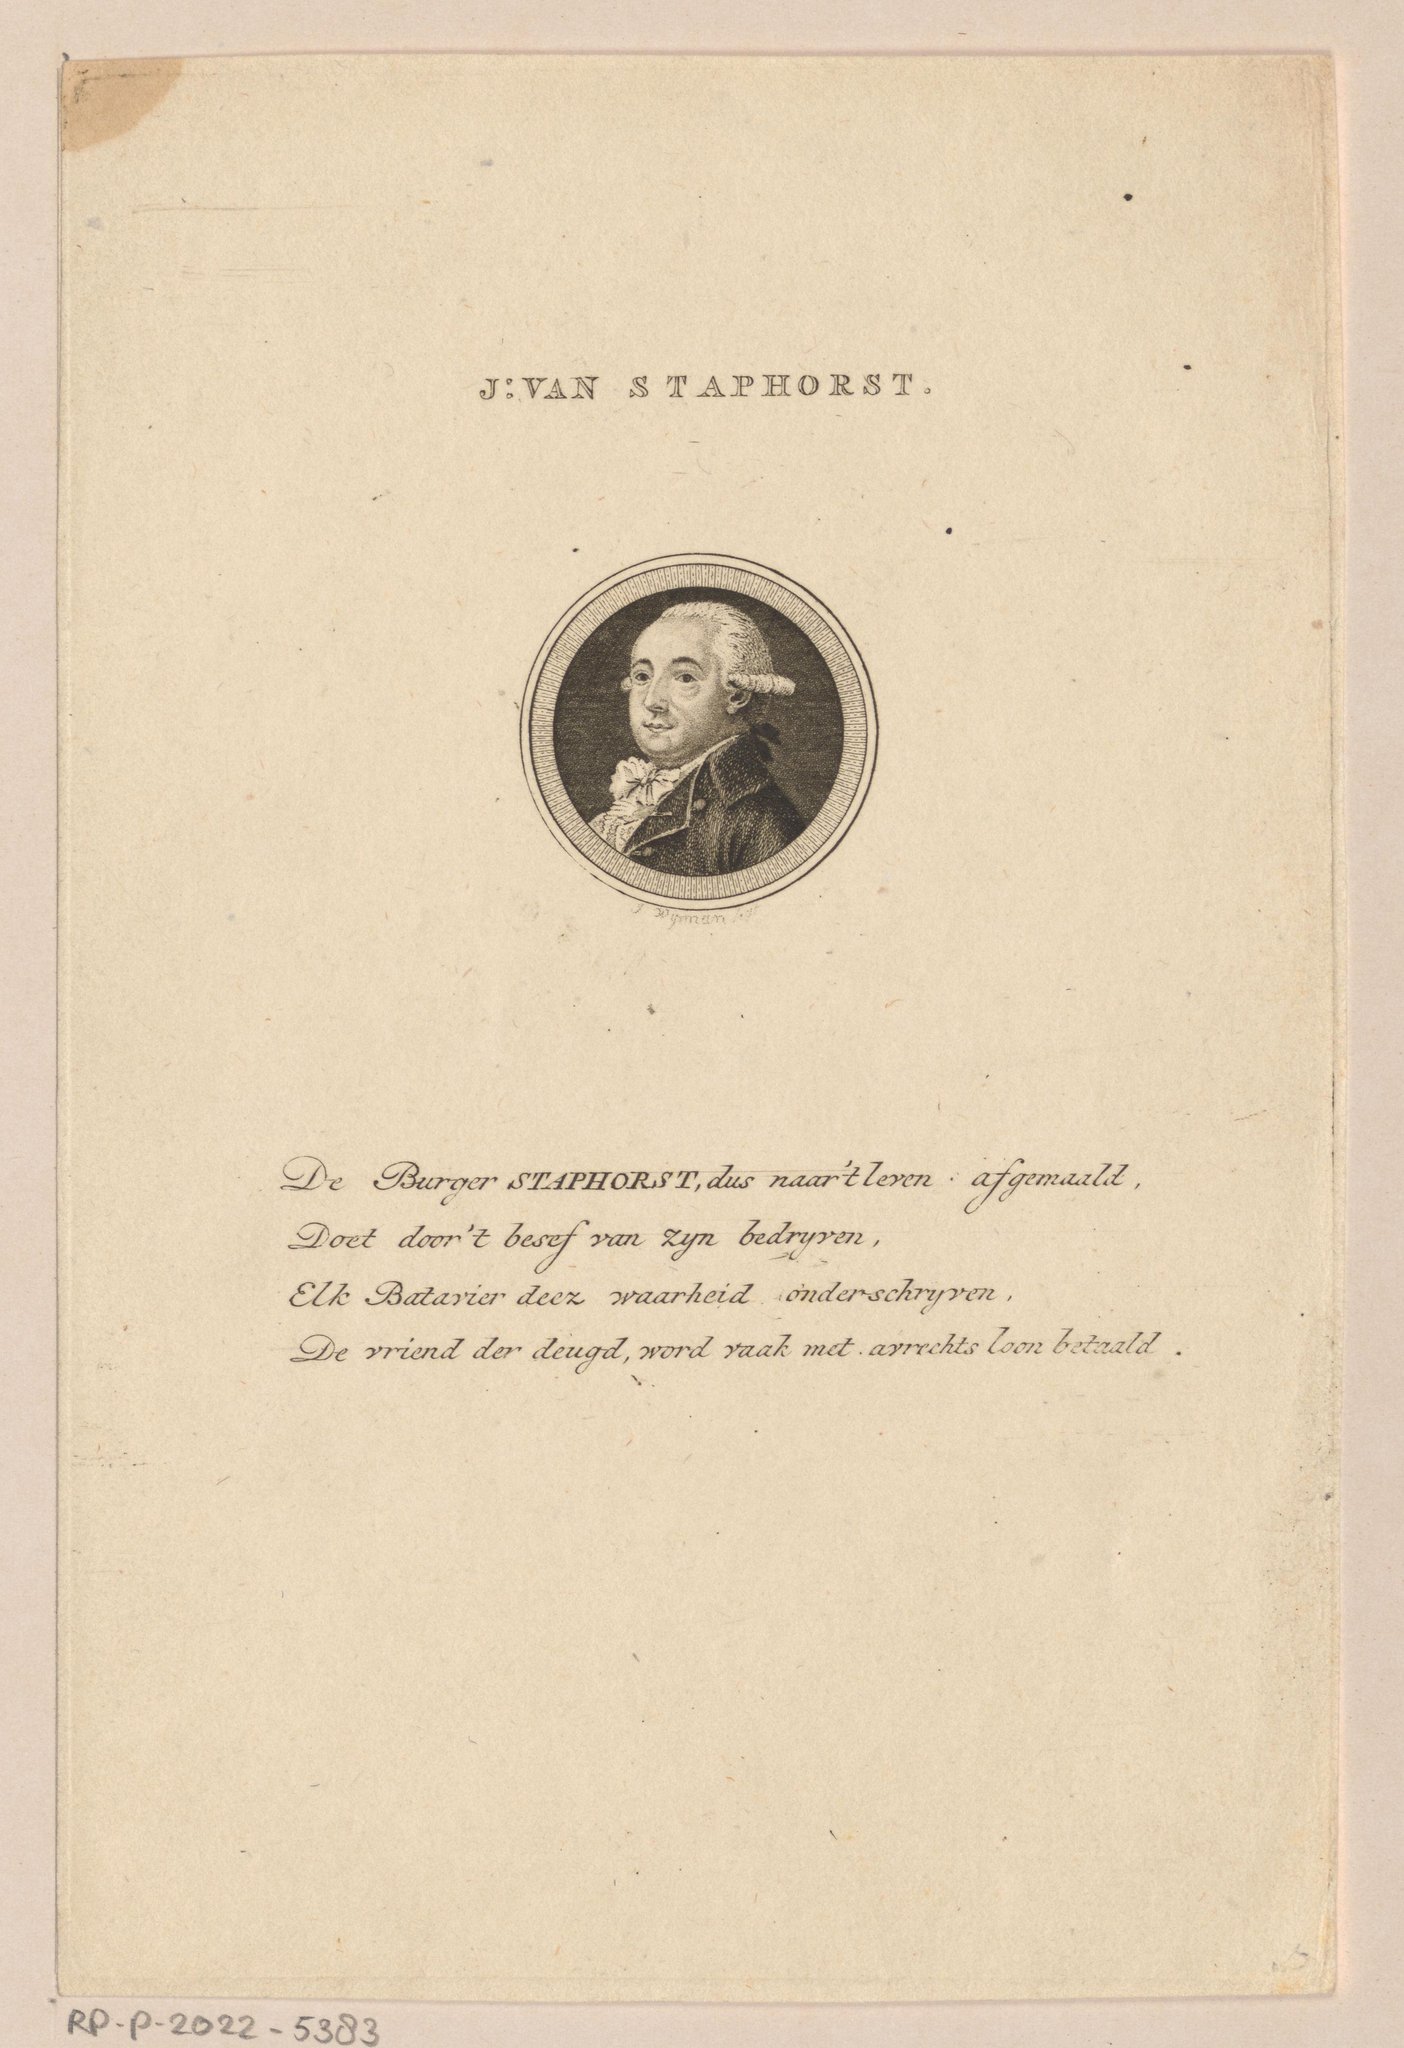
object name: print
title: Vaderlandsche Chocolaad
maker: jacobus wijsman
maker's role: print maker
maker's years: 1768-1827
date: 1794-1795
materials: paper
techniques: etching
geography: amsterdam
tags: governmental and representative bodies, historical persons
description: Prent maakt deel uit van een serie, die in drie afleveringen werd uitgegeven onder de titel: Verzameling van Afbeeldingen van Nederlandsche Mannen, beroemd geworden, wegens hunne Moed en Burgerliefde in de jongstledene Beroerten. 1794-1795. Zie Atlas van Stolk.